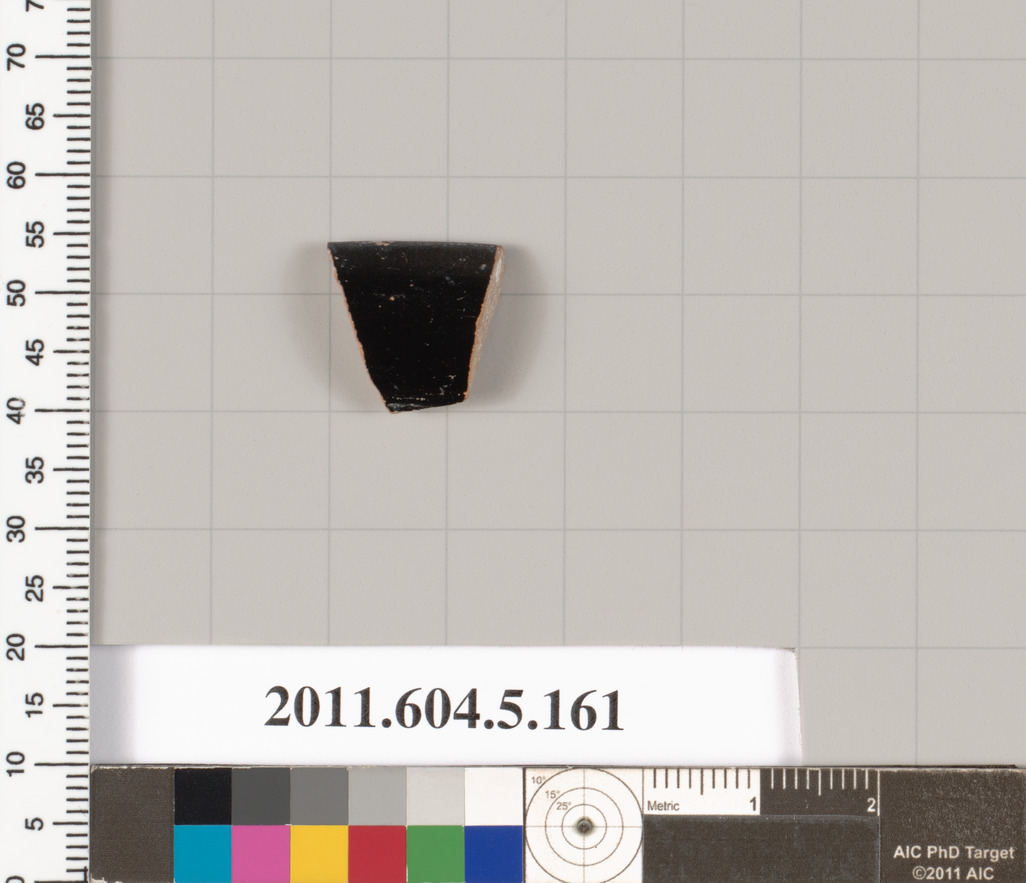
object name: kylix fragment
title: Terracotta rim fragment of a kylix (drinking cup)?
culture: greek, attic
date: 600-401 BCE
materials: terracotta